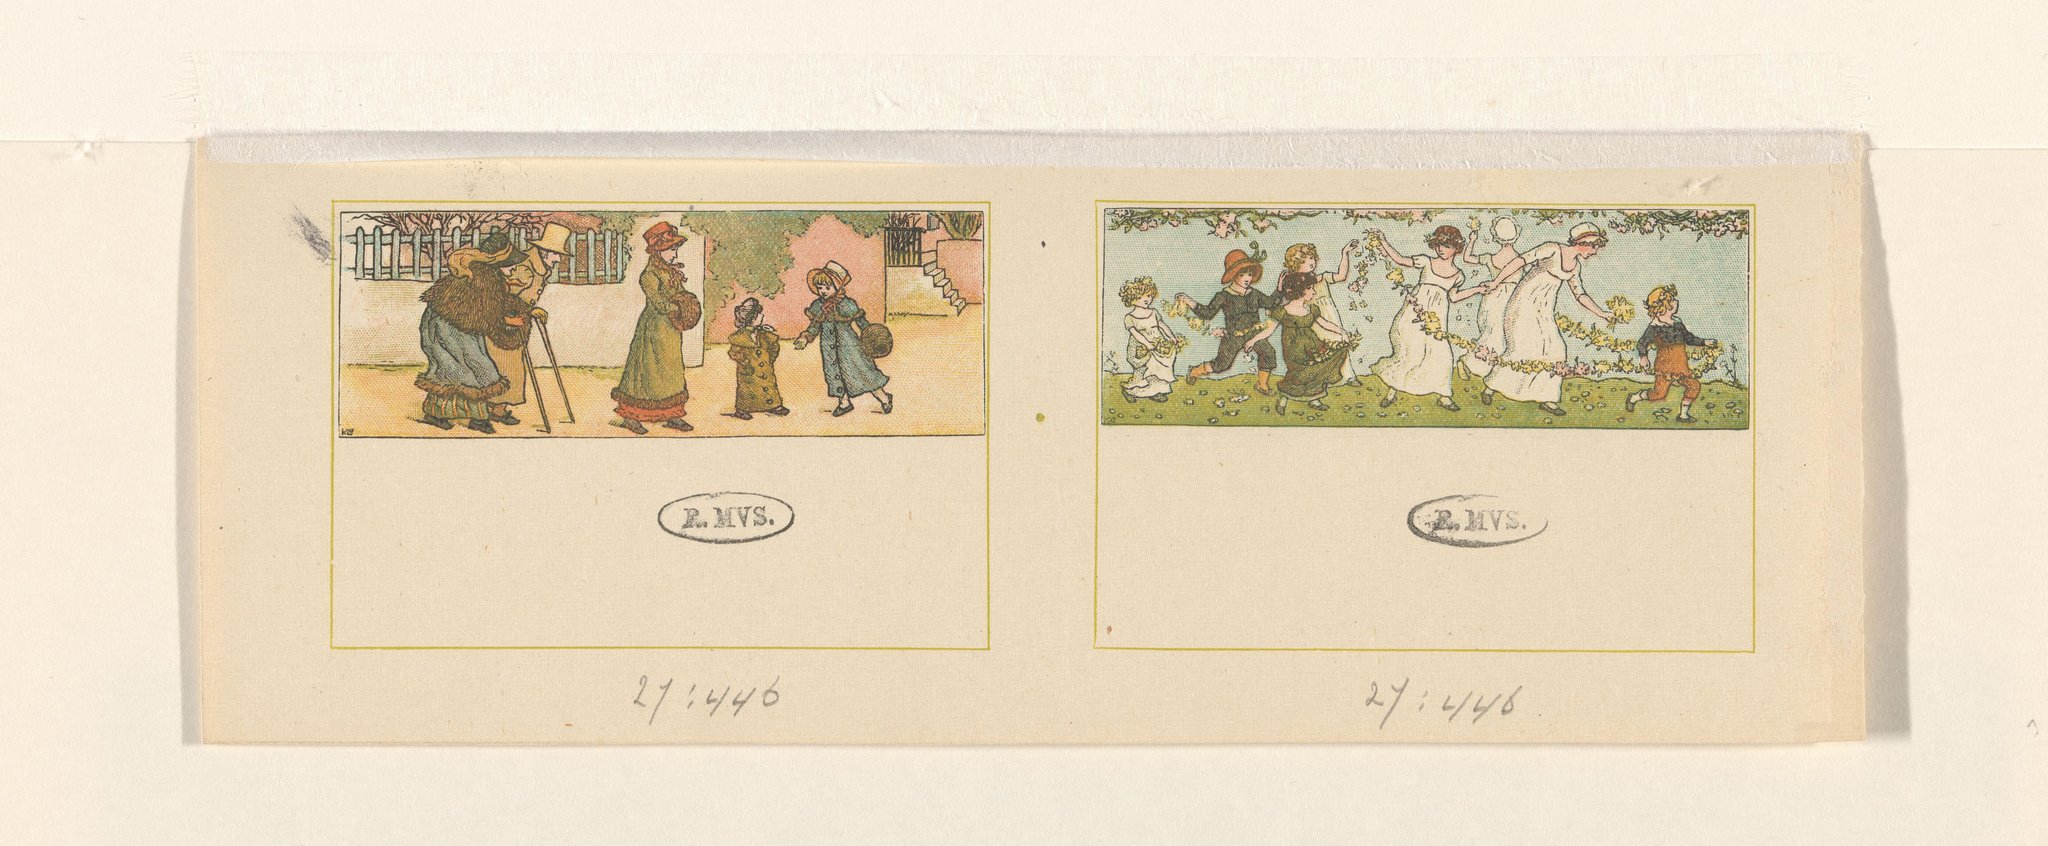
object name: print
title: Familie op straat en dansende figuren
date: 1856-1901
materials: paper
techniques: wood engraving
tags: dancing, family, descendance, street (+ city(-scape) with figures, staffage)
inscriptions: collector's mark: Lugt 2228